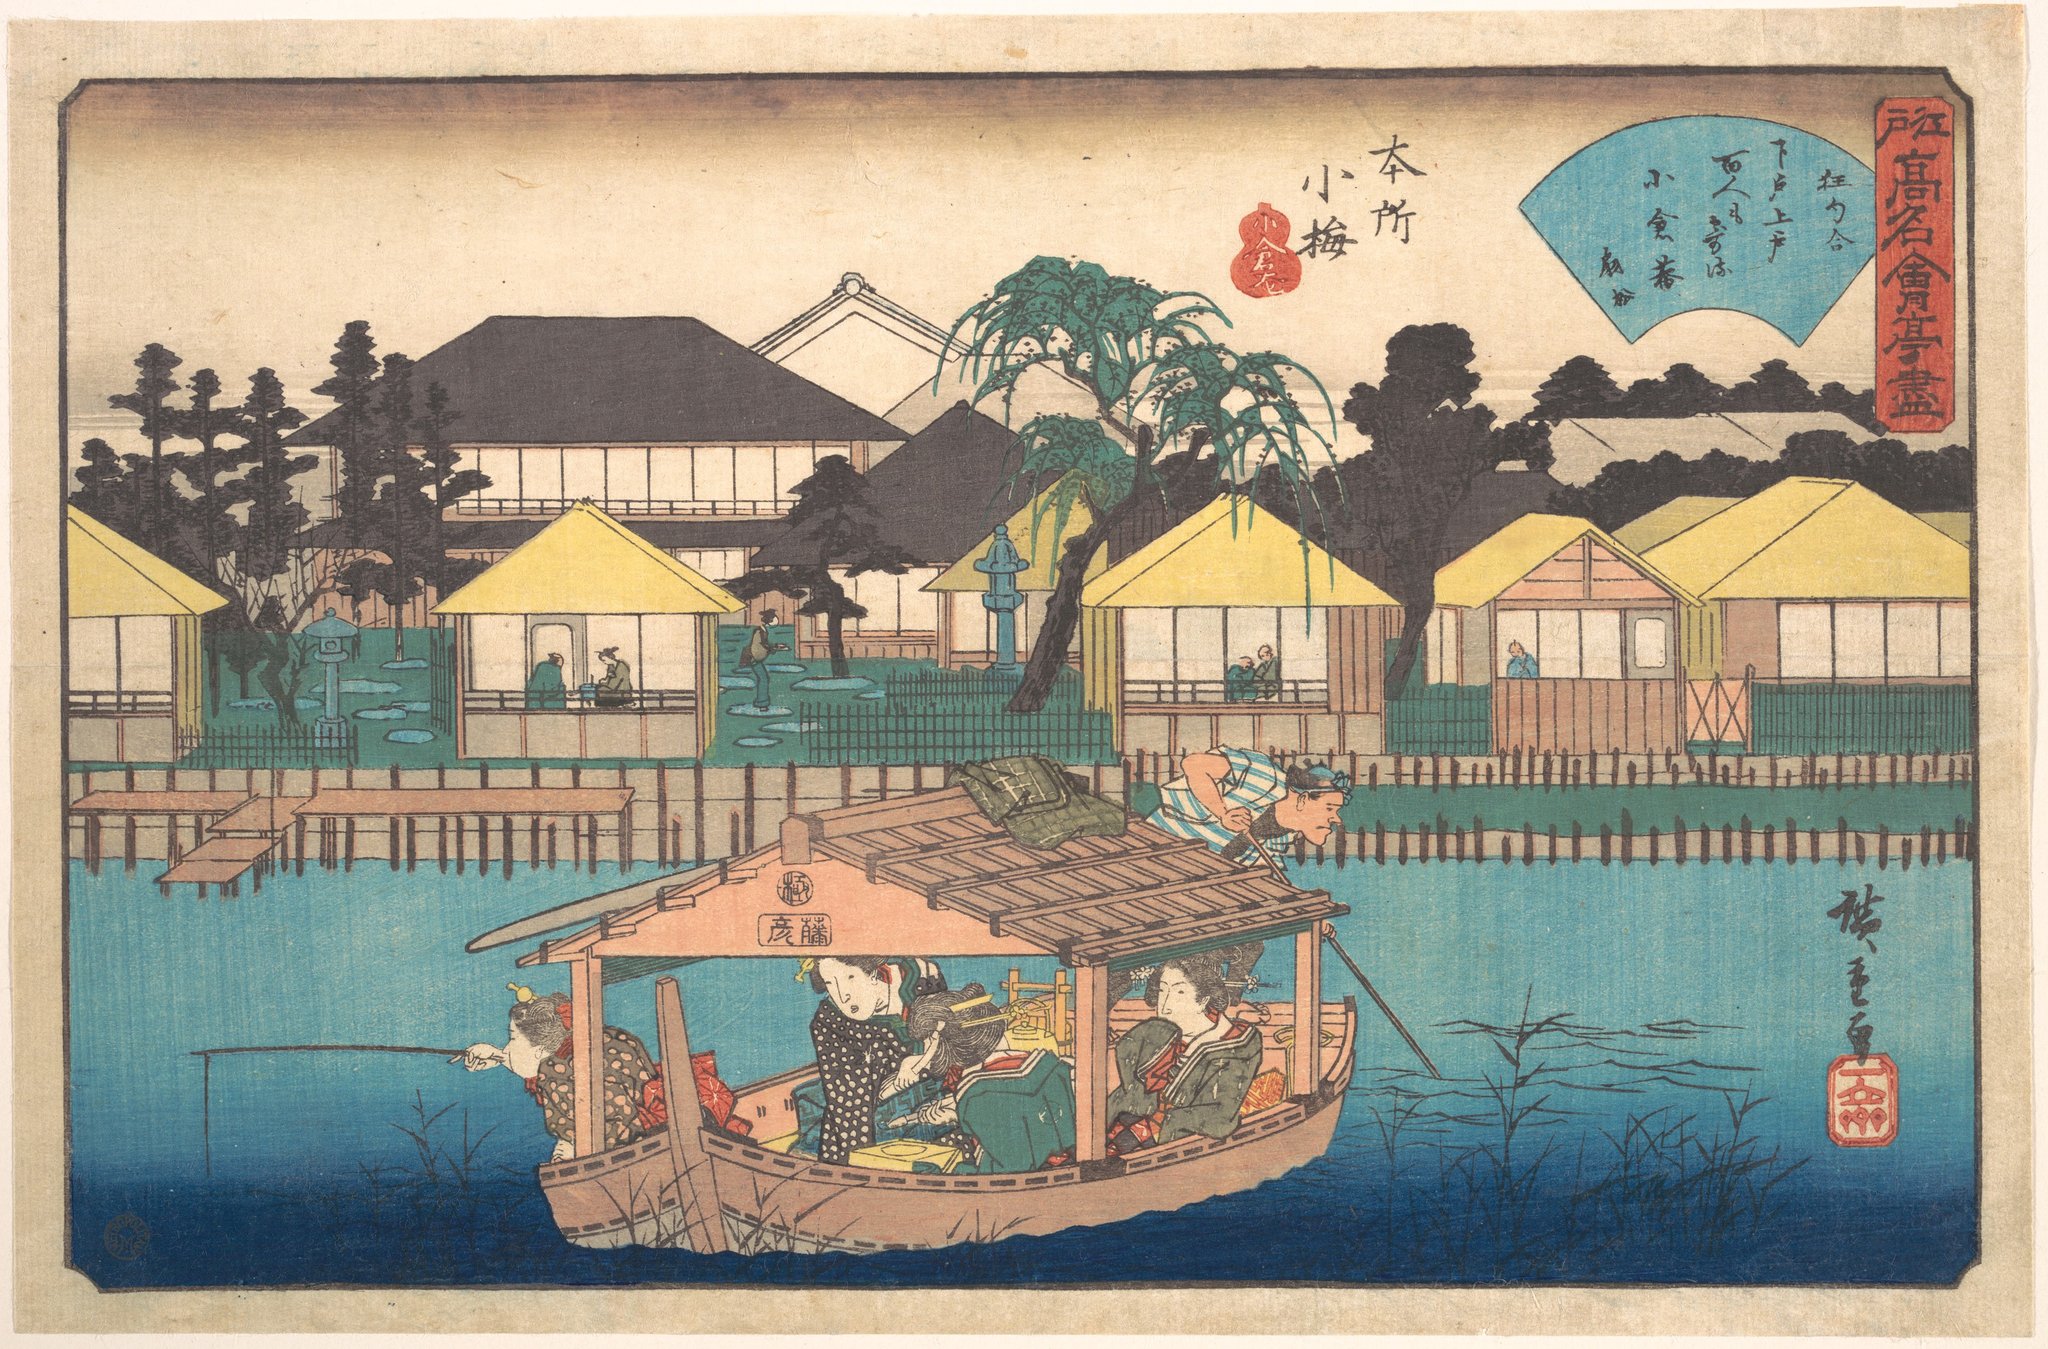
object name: print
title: Honjo Komme (Ogura-an)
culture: japanese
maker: utagawa hiroshige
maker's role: artist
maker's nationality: japanese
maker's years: 1797-1858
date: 1840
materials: ink, paper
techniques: woodblock print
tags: buildings,men,women,fishing,boats